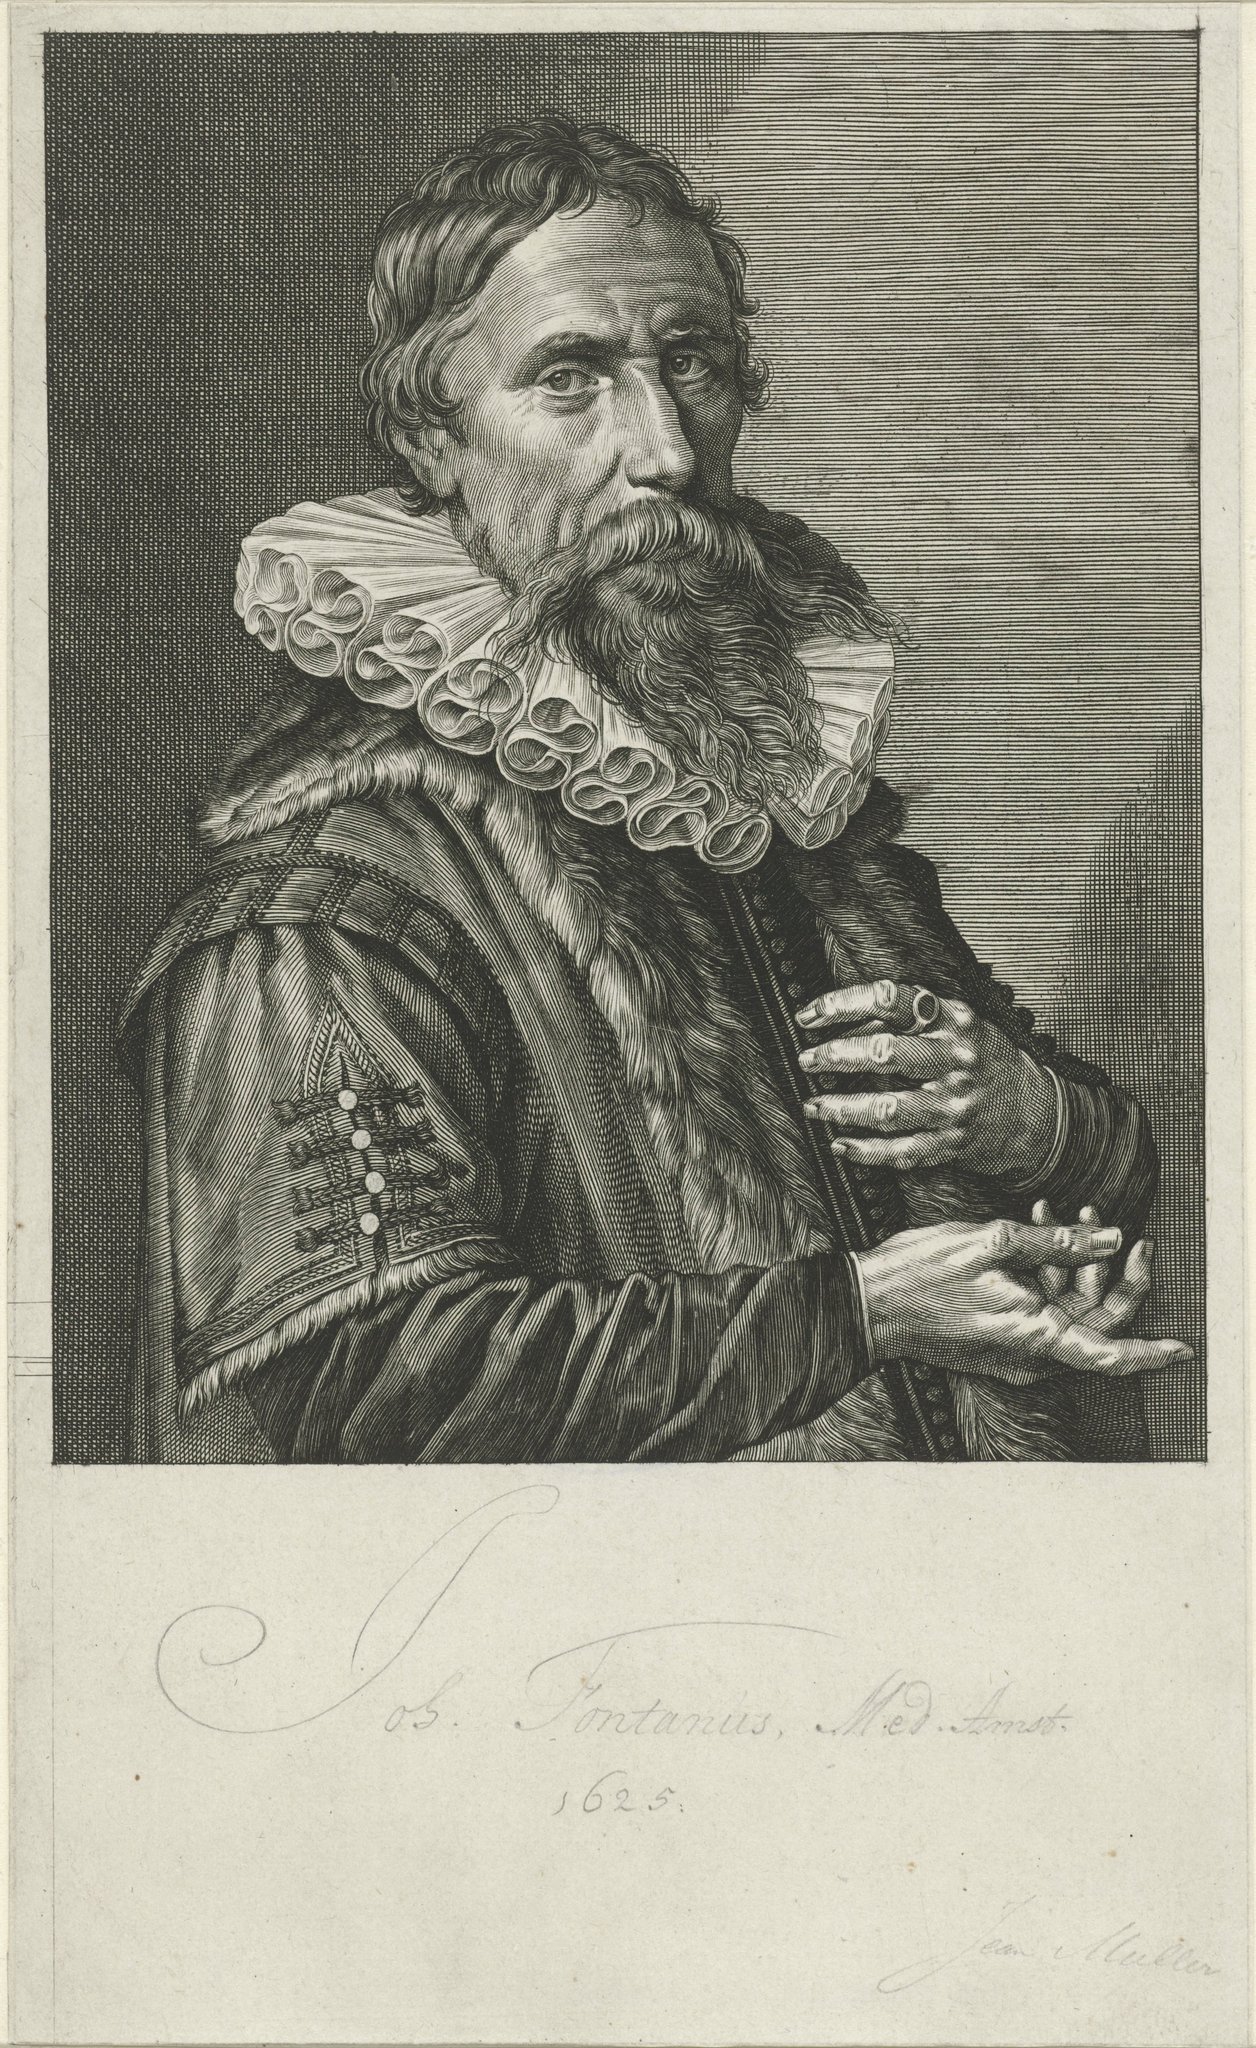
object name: print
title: Portret van Johan Fonteyn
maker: jan harmensz. muller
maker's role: draughtsman, print maker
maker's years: 1571-1628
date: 1626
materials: paper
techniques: engraving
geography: amsterdam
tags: arts, johan fonteyn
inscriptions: inscription: ‘Joh. Fontanus, Med. Amst. / 1625 / Jean Muller’, collector's mark: Lugt 2228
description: Portret van Johan Fonteyn, arts te Amsterdam.